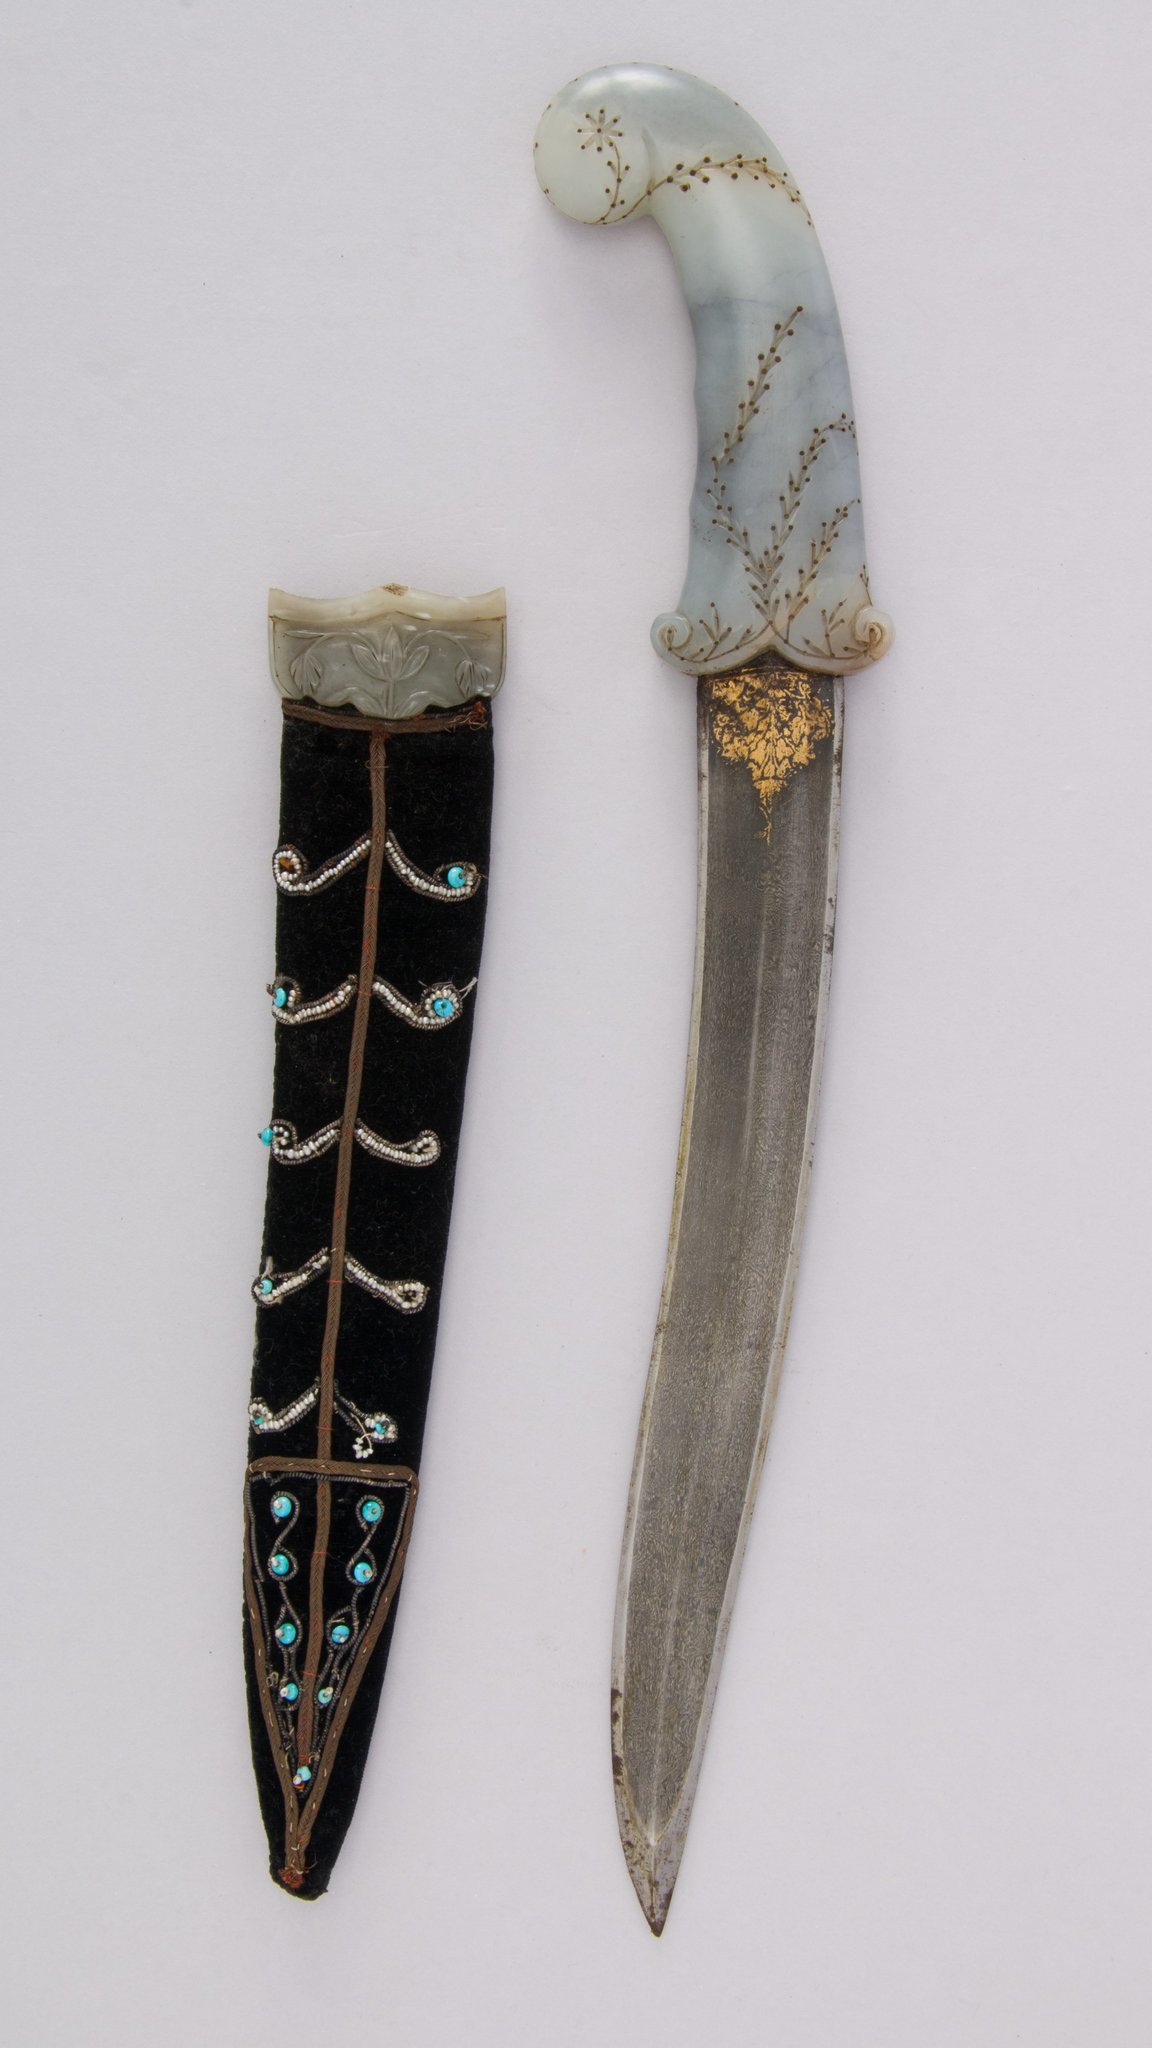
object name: dagger khanjar with sheath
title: Dagger (Khanjar) with Sheath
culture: indian, mughal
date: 1801-1900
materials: gold, jade, pearl, steel, velvet, wood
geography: india